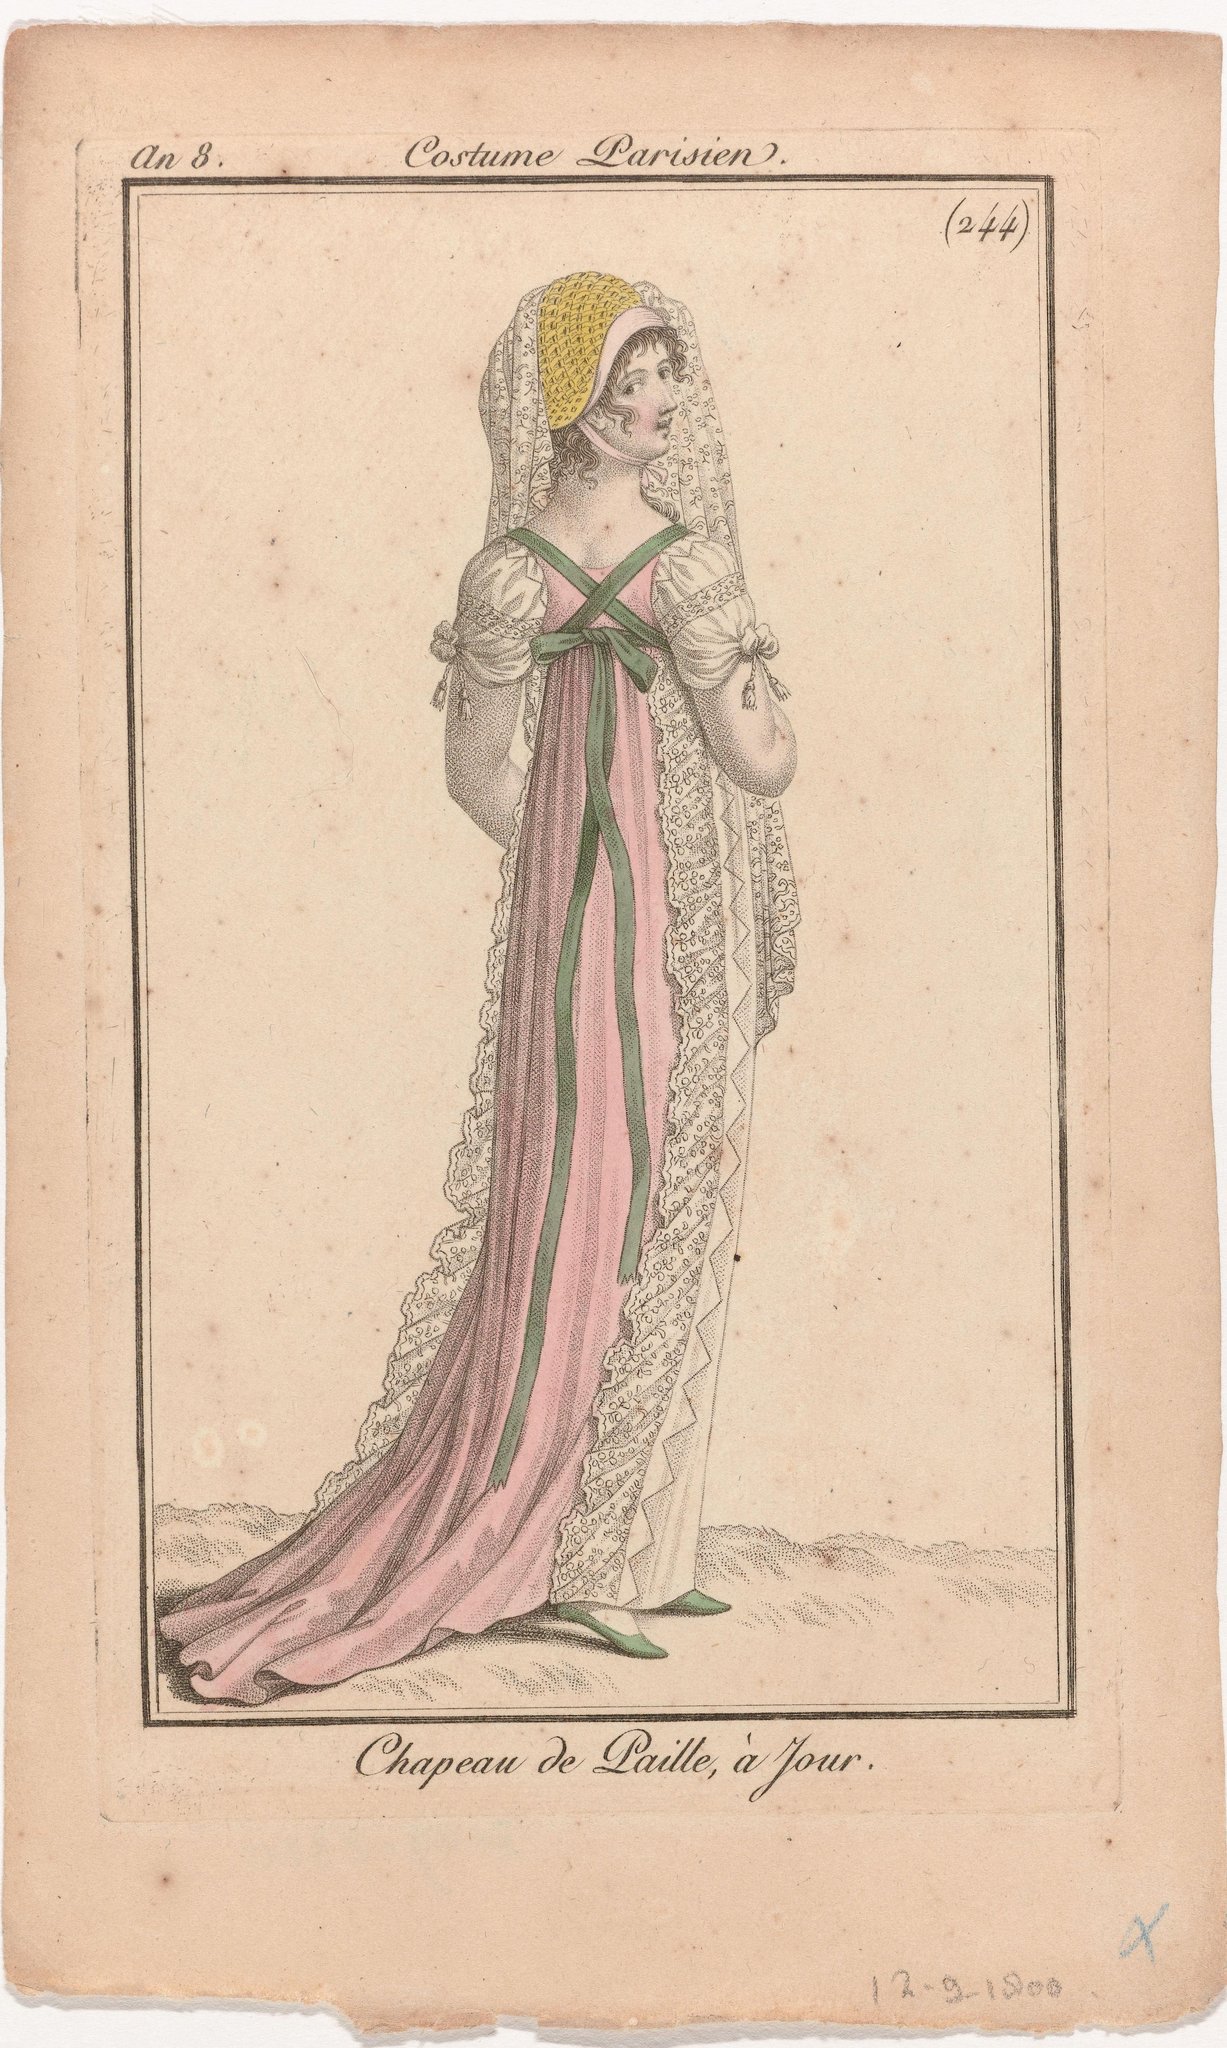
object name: fashion print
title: Journal des Dames et des Modes, Costume Parisien, 12 septembre 1800, An 8, (244) : Chapeau de Paill (...)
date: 1800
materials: paper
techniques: engraving, hand coloring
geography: paris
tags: veil (+ women's clothes), border, ribbon, braid (+ women's clothes), head-gear (+ women's clothes), fashion plates, shoes, sandals (+ women's clothes), dress, gown (+ women's clothes), apron (+ women's clothes)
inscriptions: caption: ‘Chapeau de Paille, à Jour.’, title: ‘Costume Parisien.’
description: Vrouw, op de rug gezien, met op het hoofd een strohoed 'à jour' met sluier. Zij draagt een lang schort, afgezet met een geplooide strook stof. Japon met korte mouwen en sleep. Op de rug een gekruist lint met strik. platte schoenen met puntige neuzen. De prent maakt deel uit van het modetijdschrift Journal des Dames et des Modes, uitgegeven door Pierre de la Mésangère, Parijs, 1797-1839.